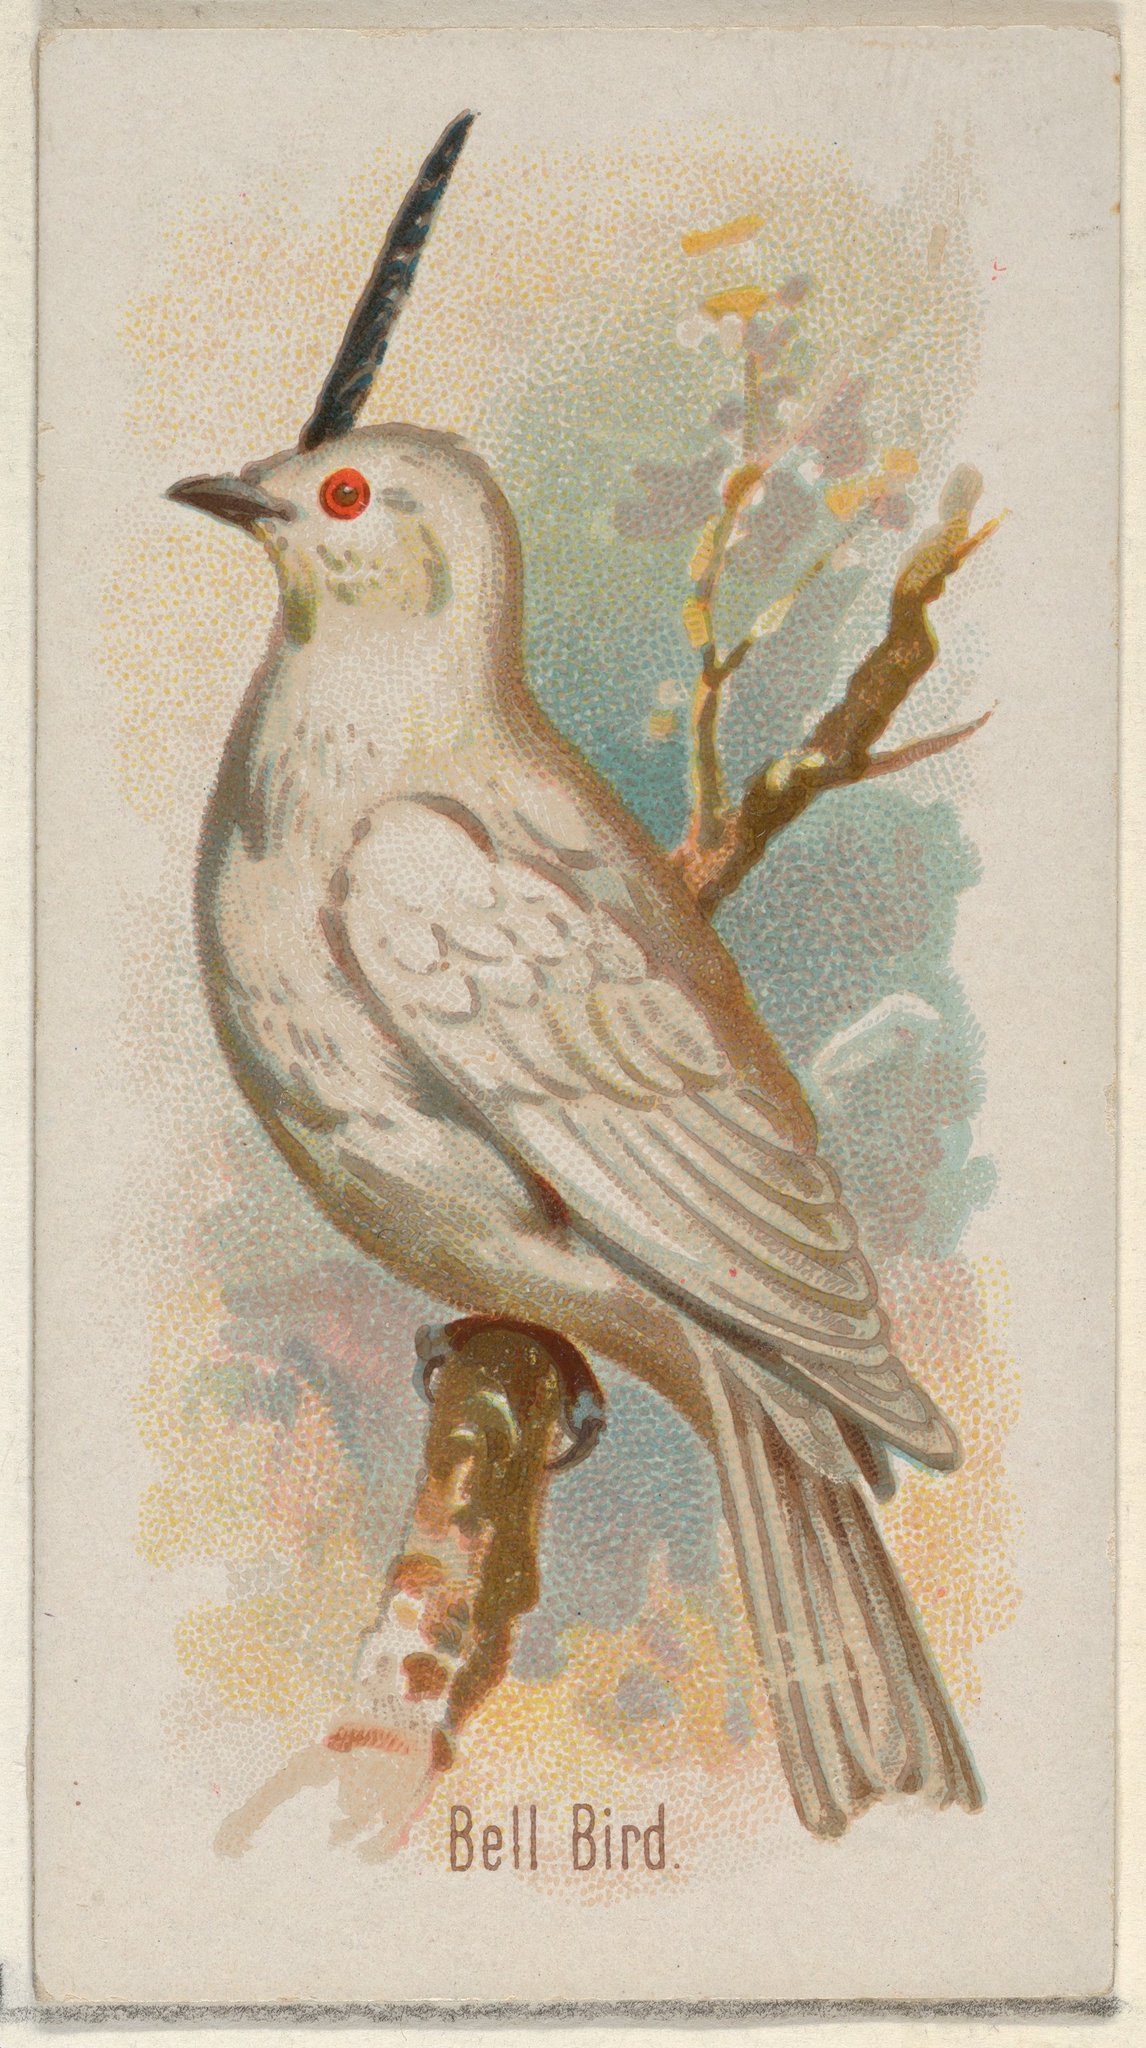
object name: print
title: Bell Bird, from the Song Birds of the World series (N23) for Allen & Ginter Cigarettes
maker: allen & ginter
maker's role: publisher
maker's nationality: american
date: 1890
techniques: color lithograph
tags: birds